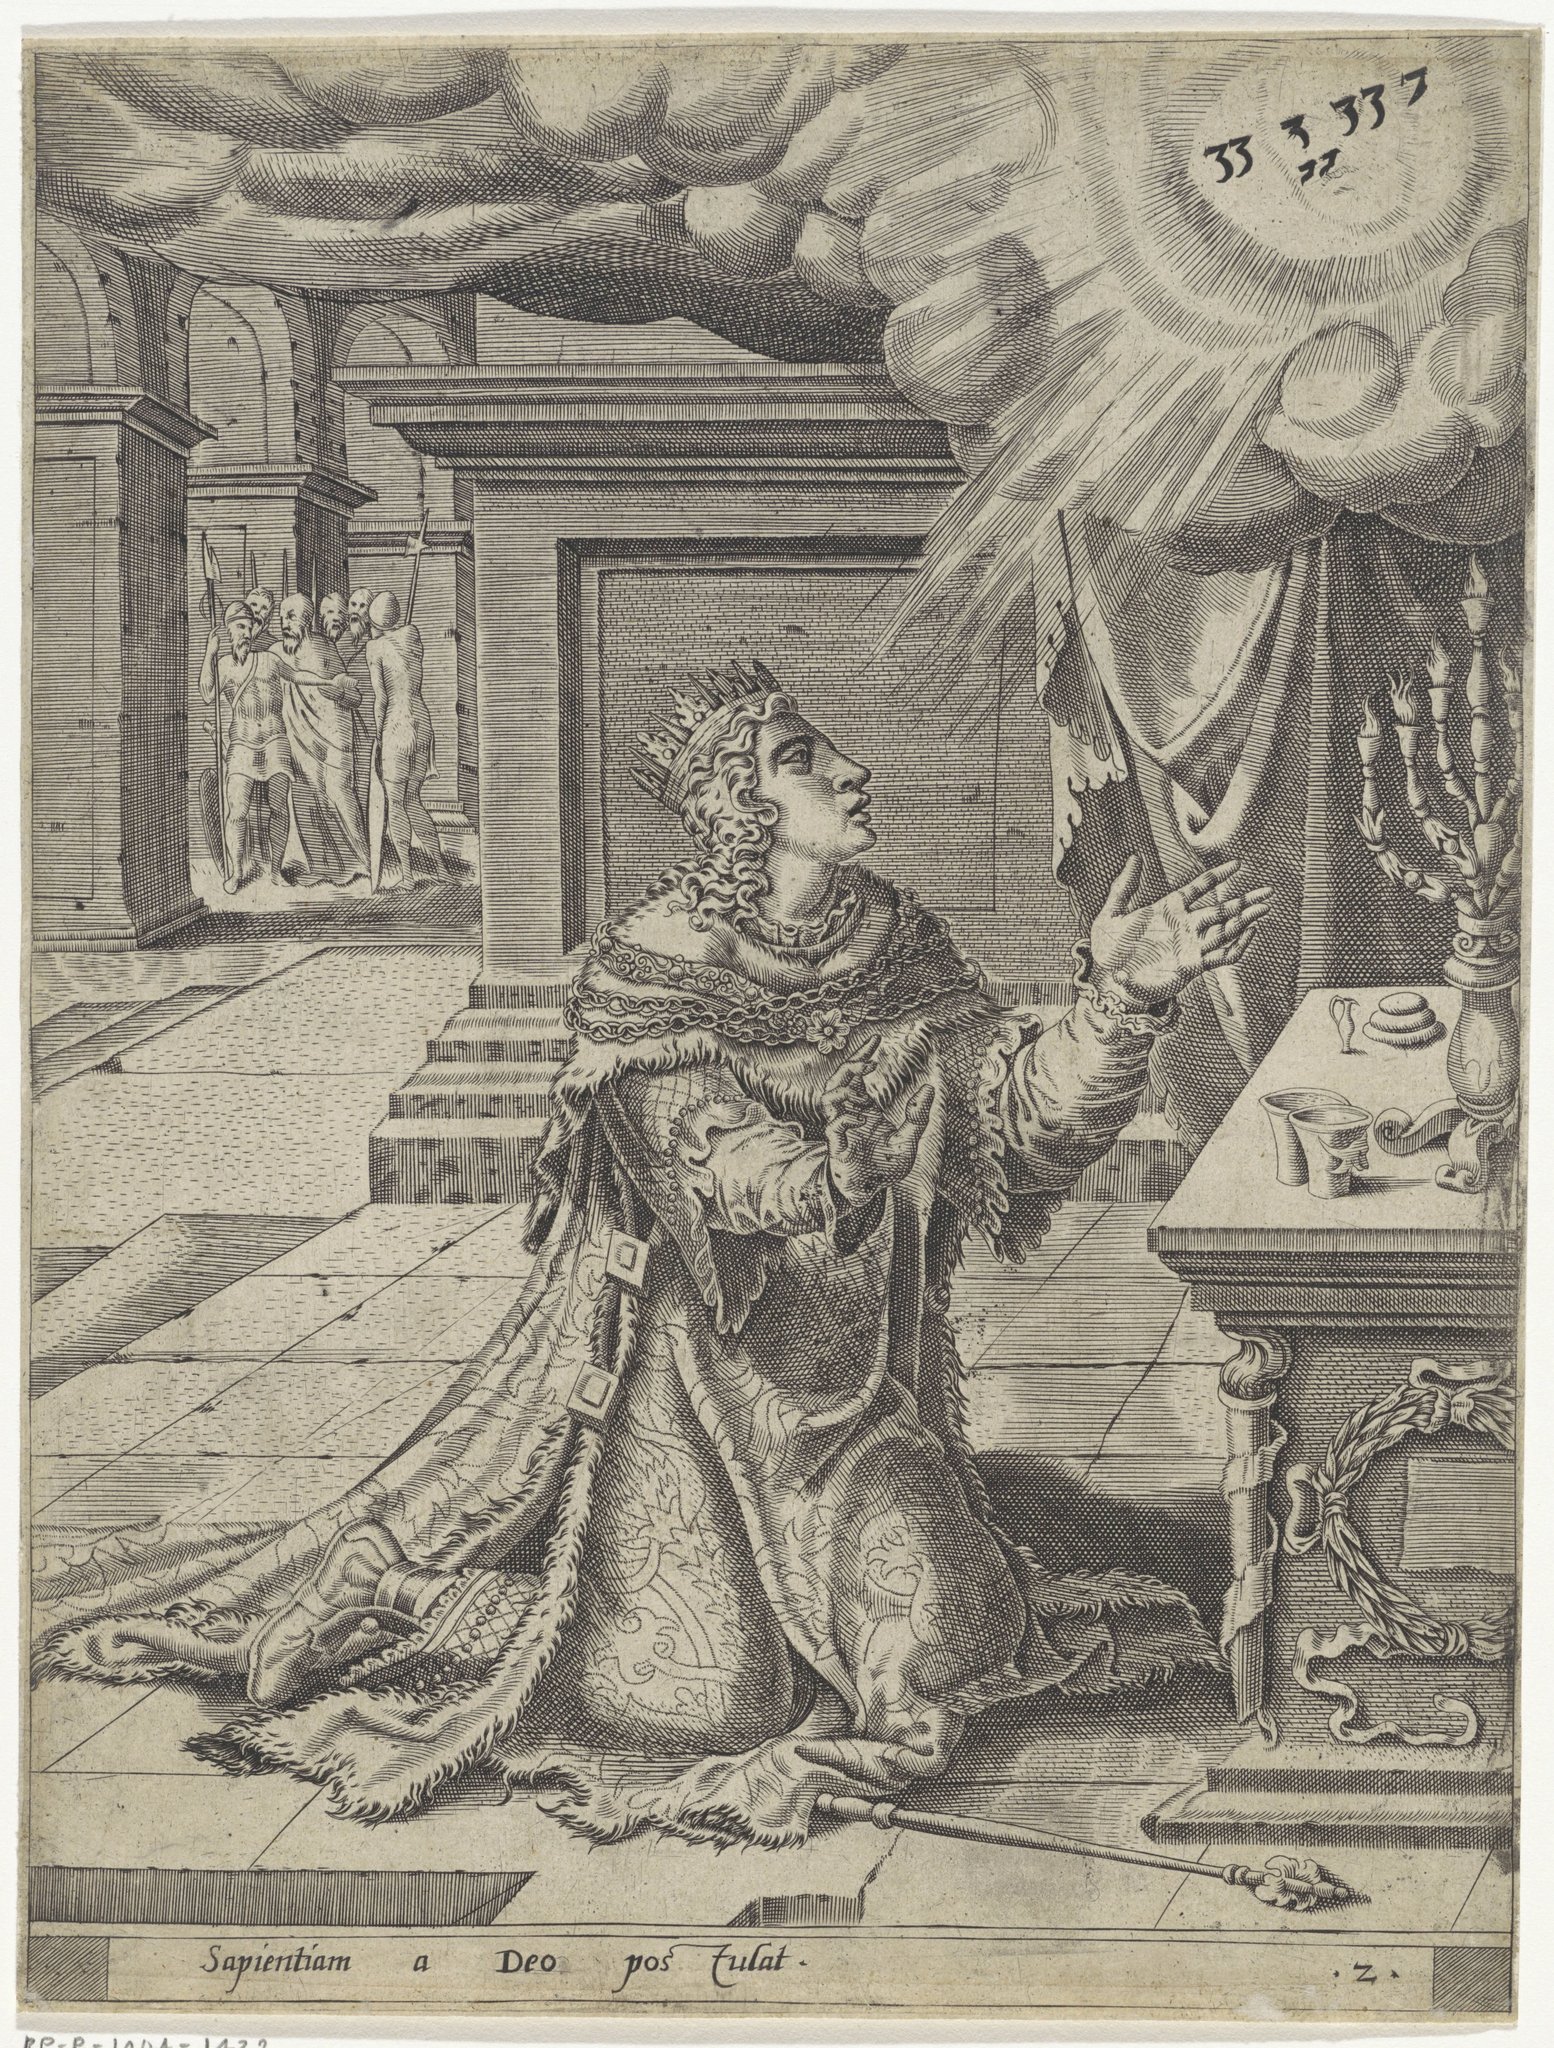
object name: print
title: Salomo bidt tot God om wijsheid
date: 1554-1595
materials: paper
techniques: engraving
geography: antwerp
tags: solomon's prayer for wisdom (1 kings 3:4-15)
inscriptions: collector's mark: Lugt 2228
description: Koning Salomo knielt en bidt tot God om wijsheid. Op de achtergrond enkele soldaten. Onderaan in de marge een éénregelig onderschrift in het Latijn.